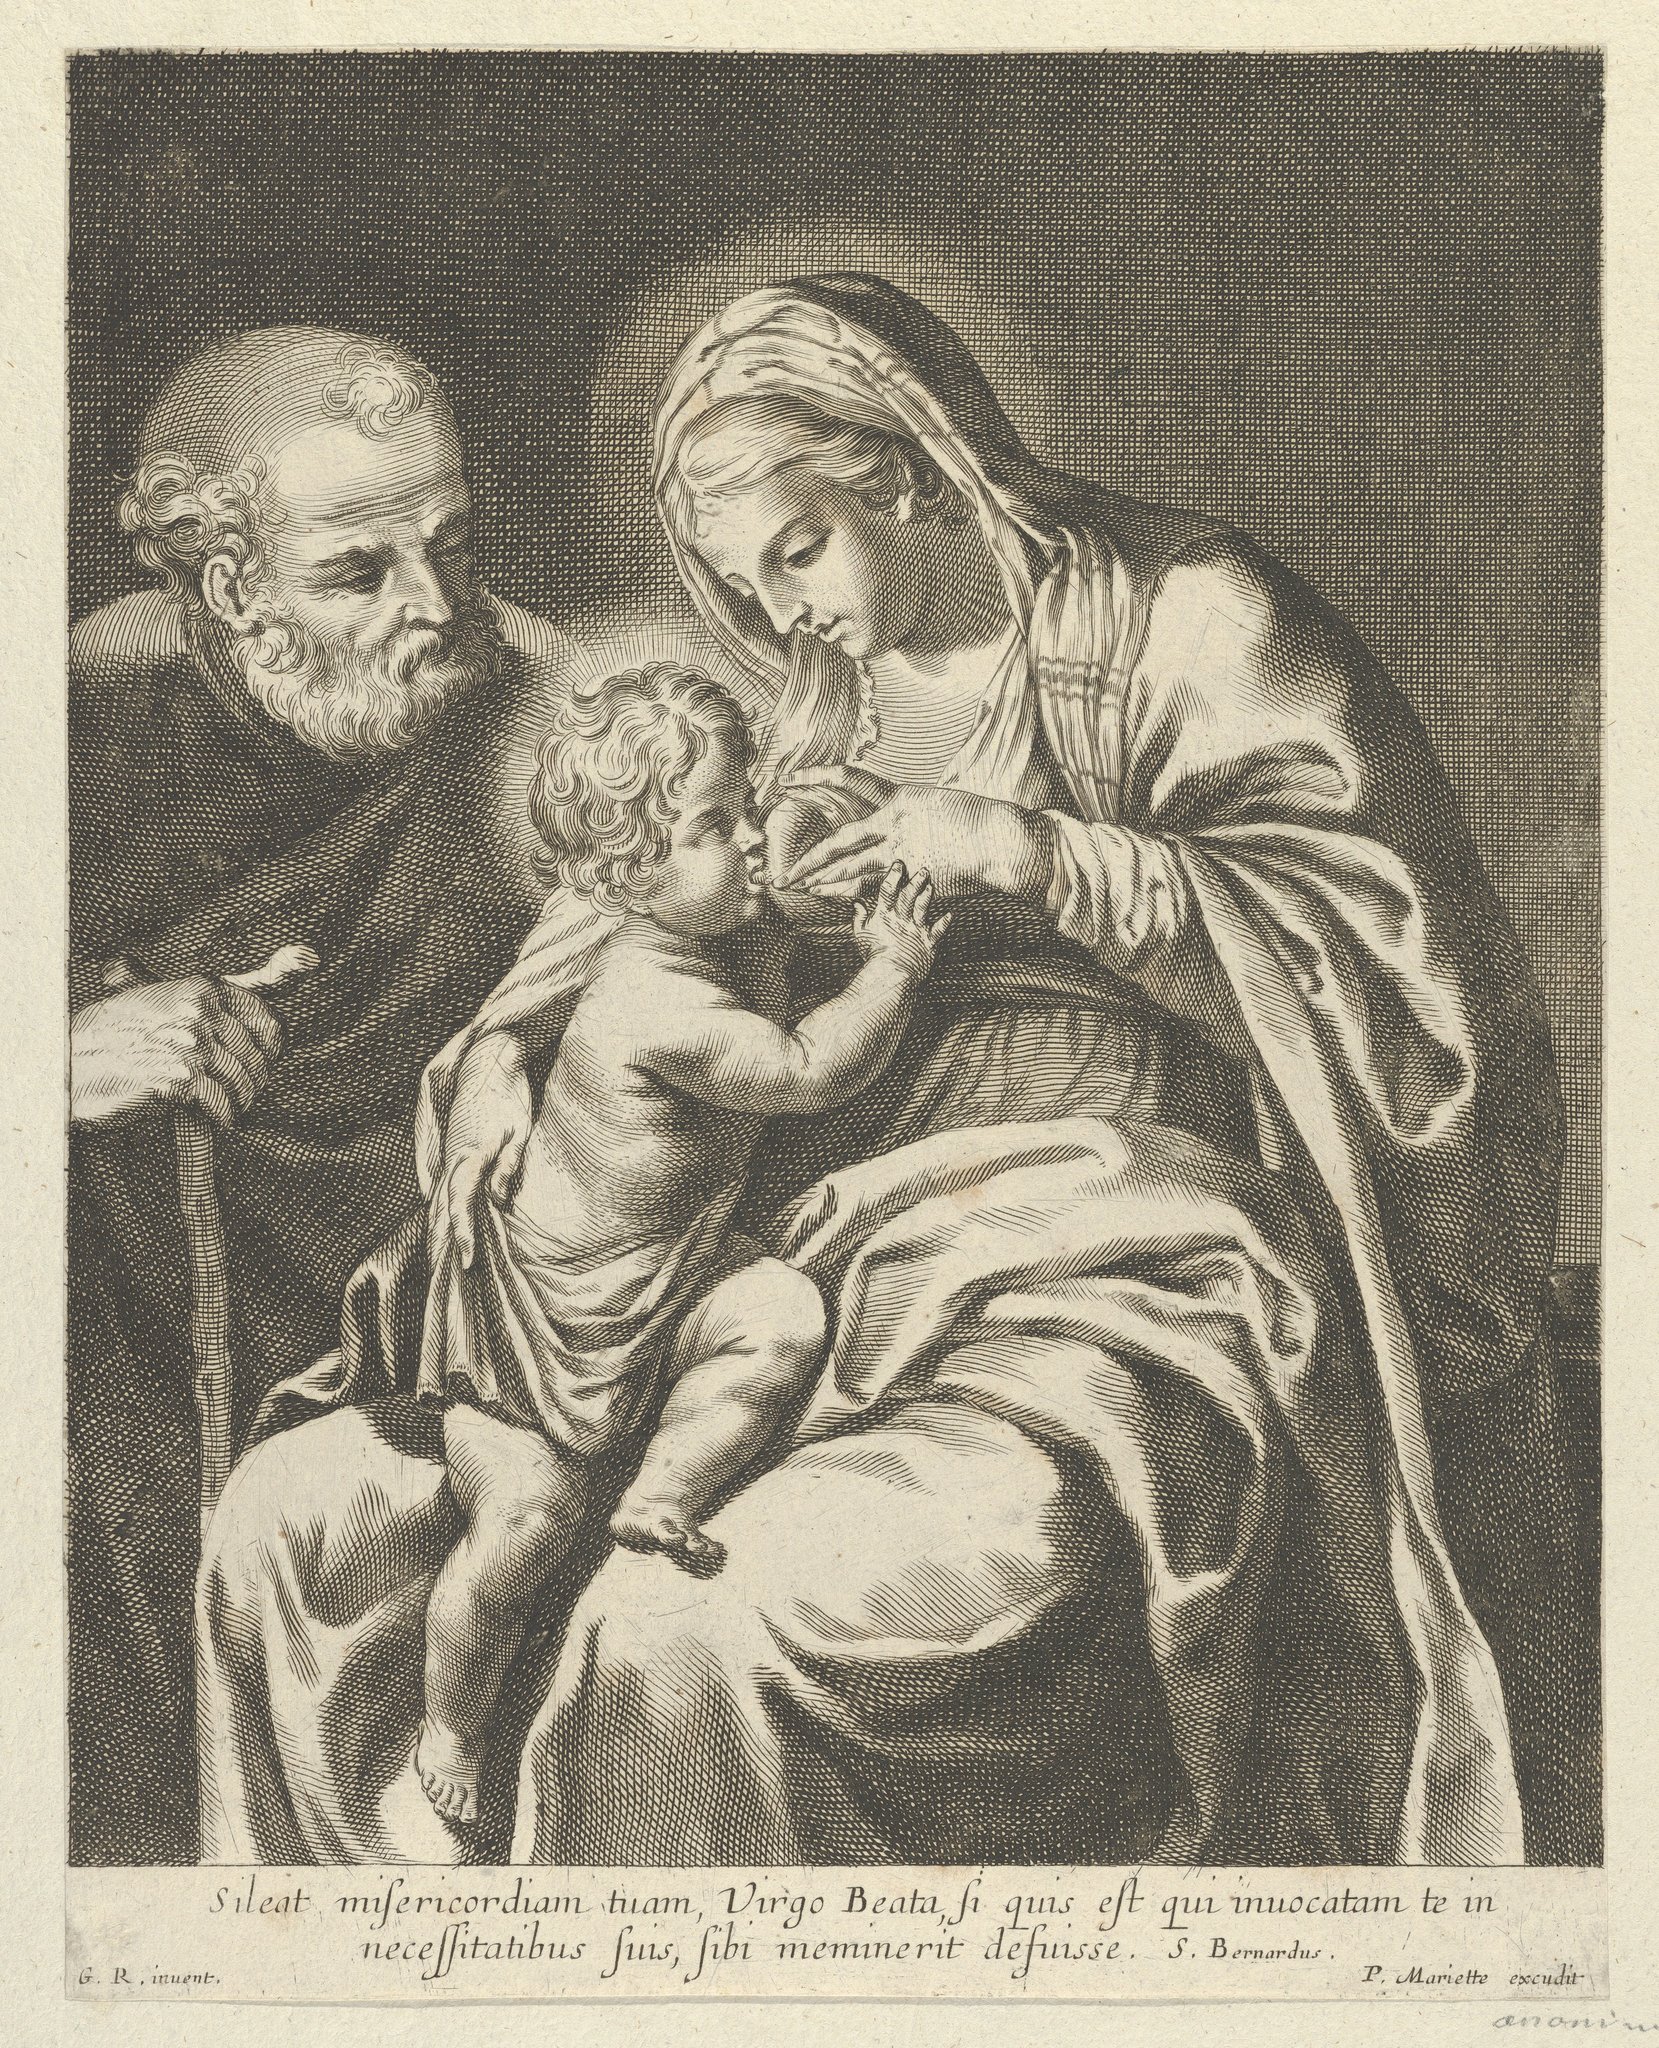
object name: print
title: The Virgin nursing the infant Christ, Joseph at left, after Reni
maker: Anonymous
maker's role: artist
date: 1600-1700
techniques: engraving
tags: virgin mary,jesus,joseph,nursing